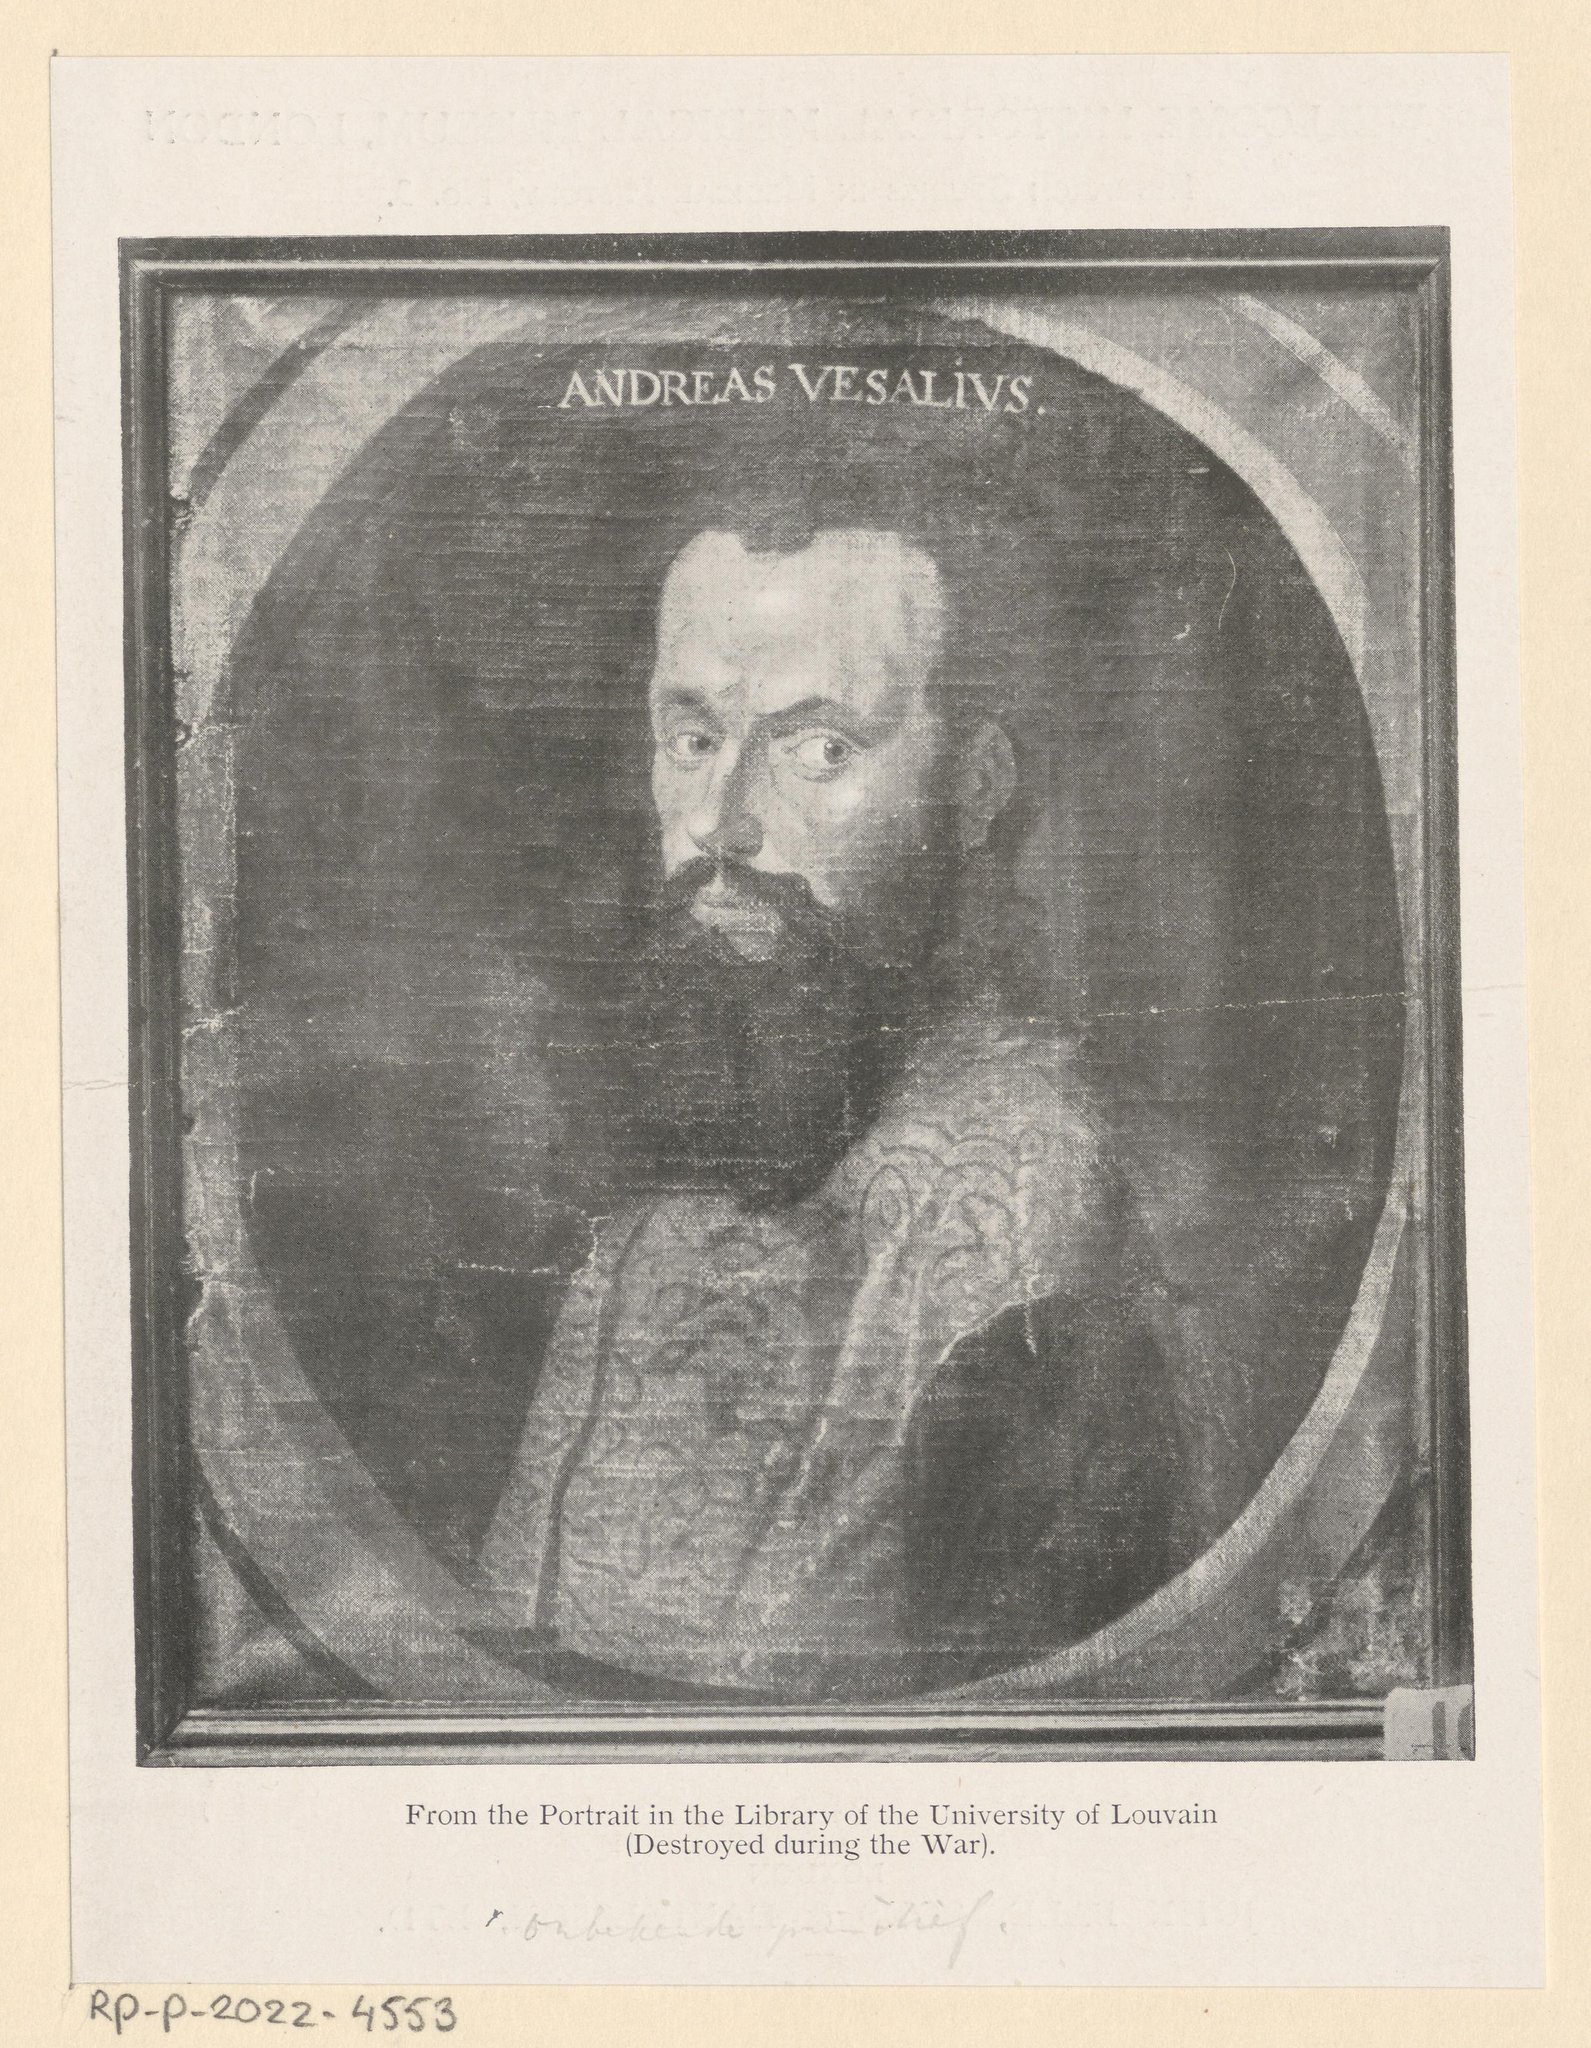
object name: photomechanical print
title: Portret van Andreas Vesalius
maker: Anonymous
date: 1925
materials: paper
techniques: letterpress printing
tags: brussels, scholar, philosopher, historical persons, physician, doctor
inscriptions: inscription: ‘MAGGS BROTHERS’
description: Fotomechanische afdruk komt uit een editie van: Paul Heger et al, 'The Iconography of Andreas Vesalius: André Vésale, Anatomist and Physician 1514-1564', Research studies in medical history 3 (1925).